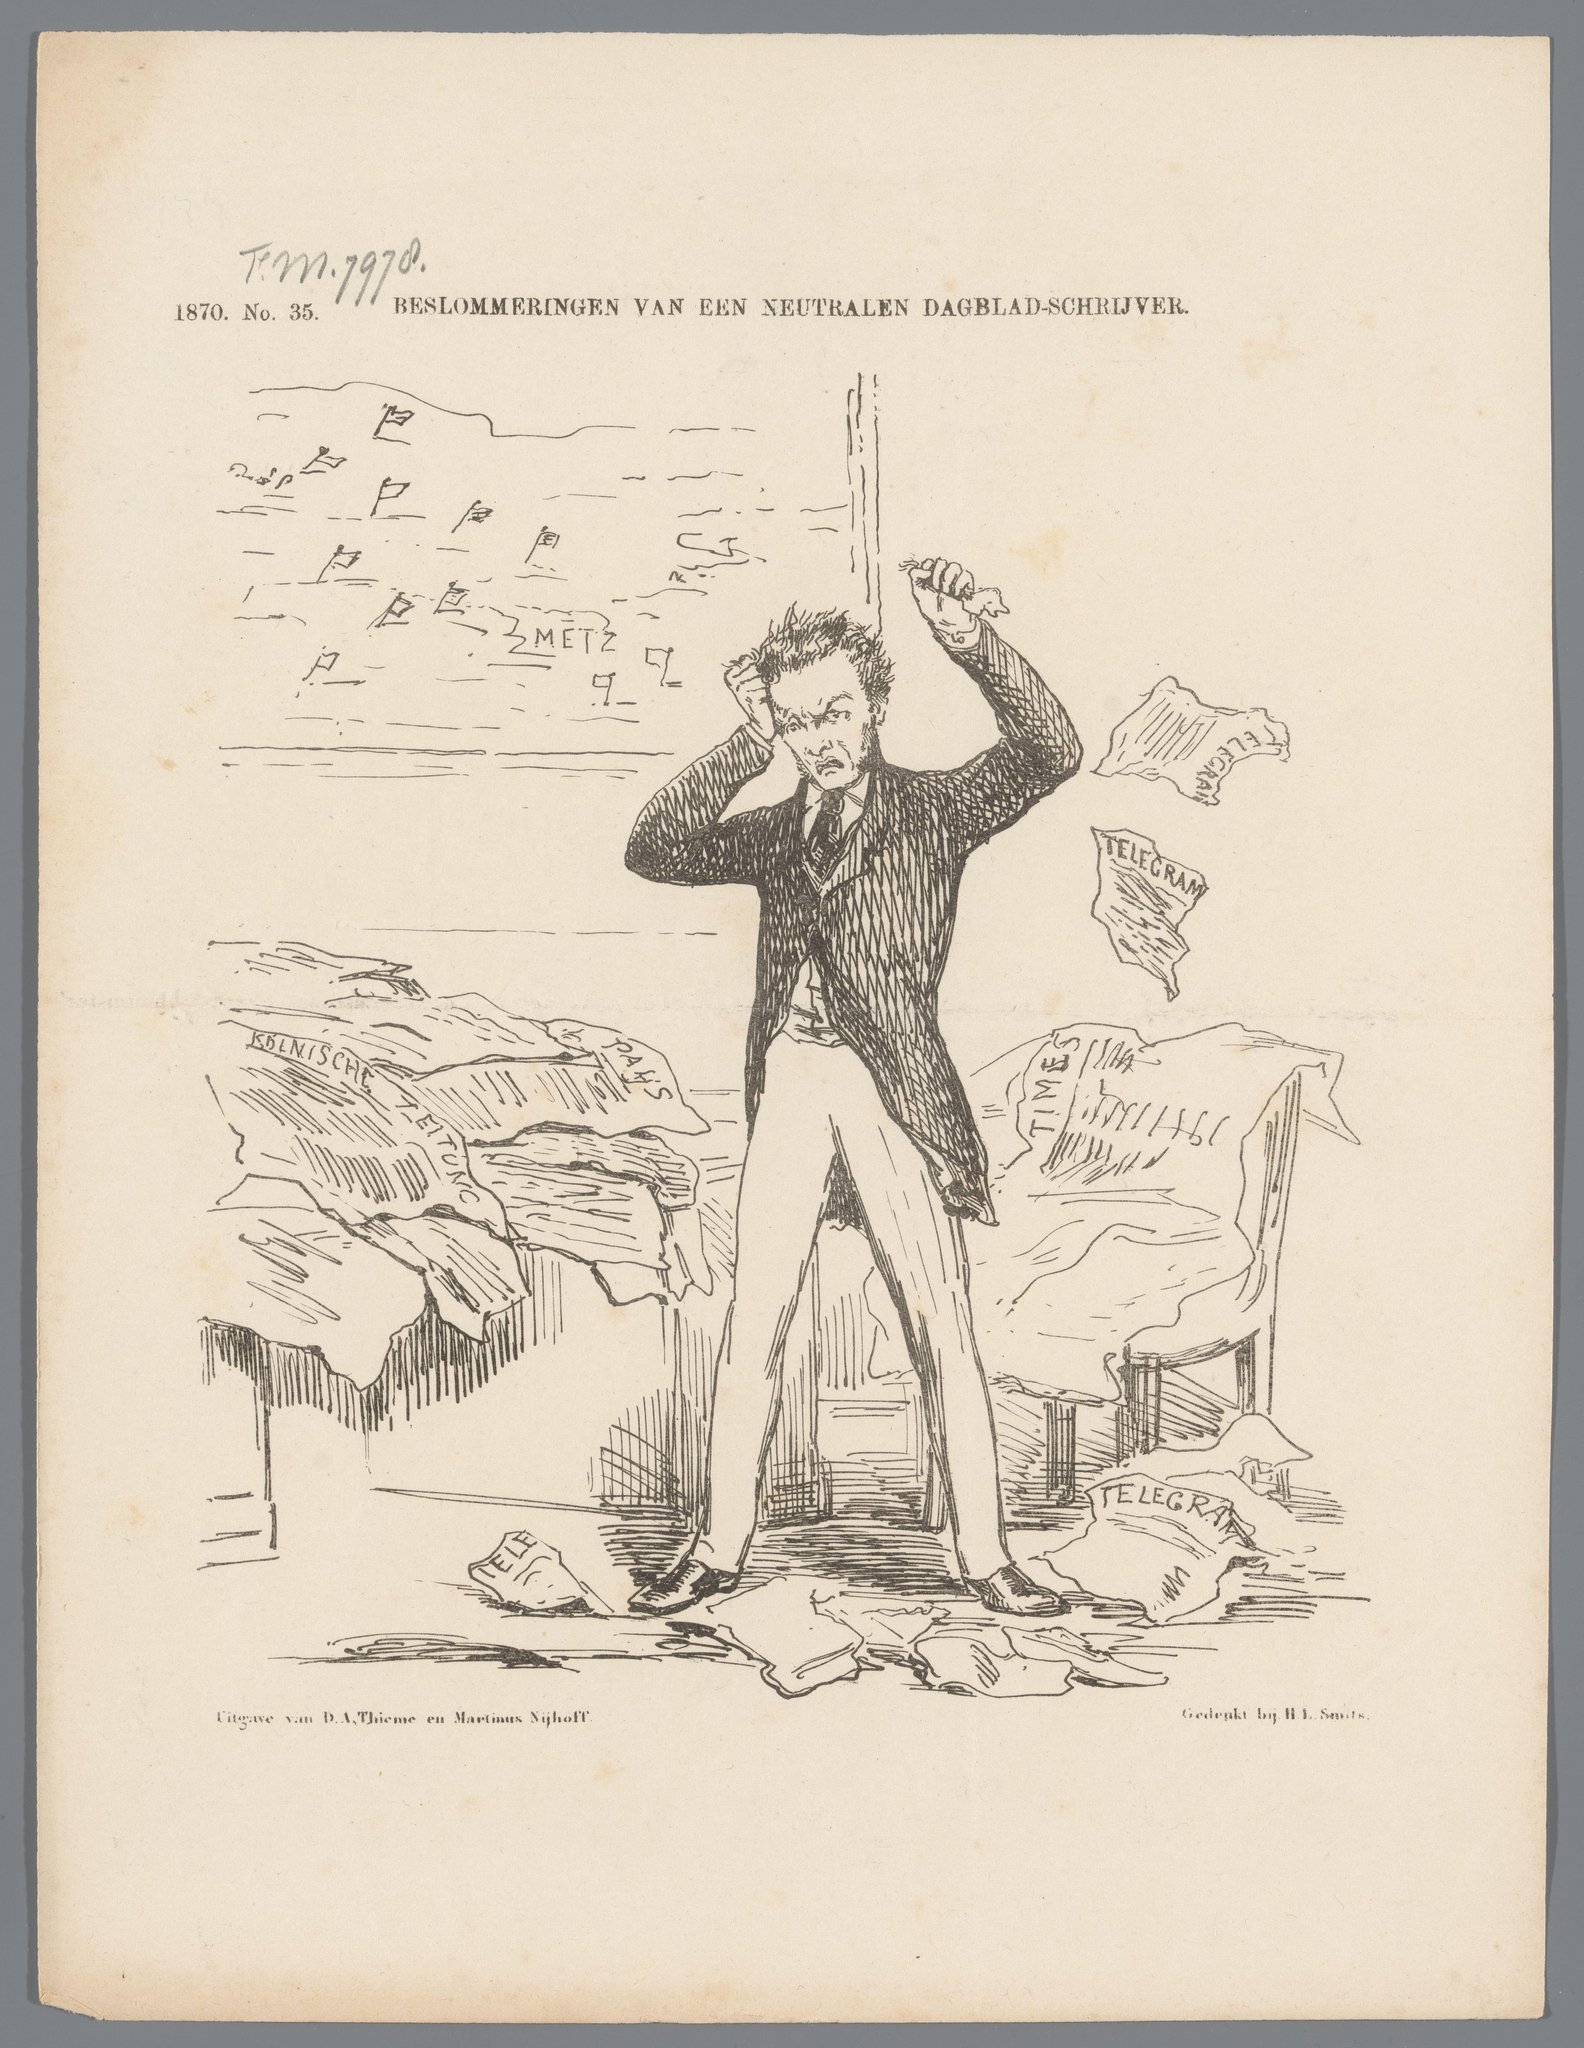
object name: cartoon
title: Spotprent over de oorlog tussen Frankrijk en Duitsland, 1870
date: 1870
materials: paper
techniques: lithograph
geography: arnhem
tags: journalist, reporter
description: Spotprent nav de oorlog tussen Frankrijk en Duitsland. Een wanhopige journalist rukt zich de haren uit het hoofd. Plaat verschenen bij het weekblad De Nederlandsche Spectator, nr. 35, 1870.